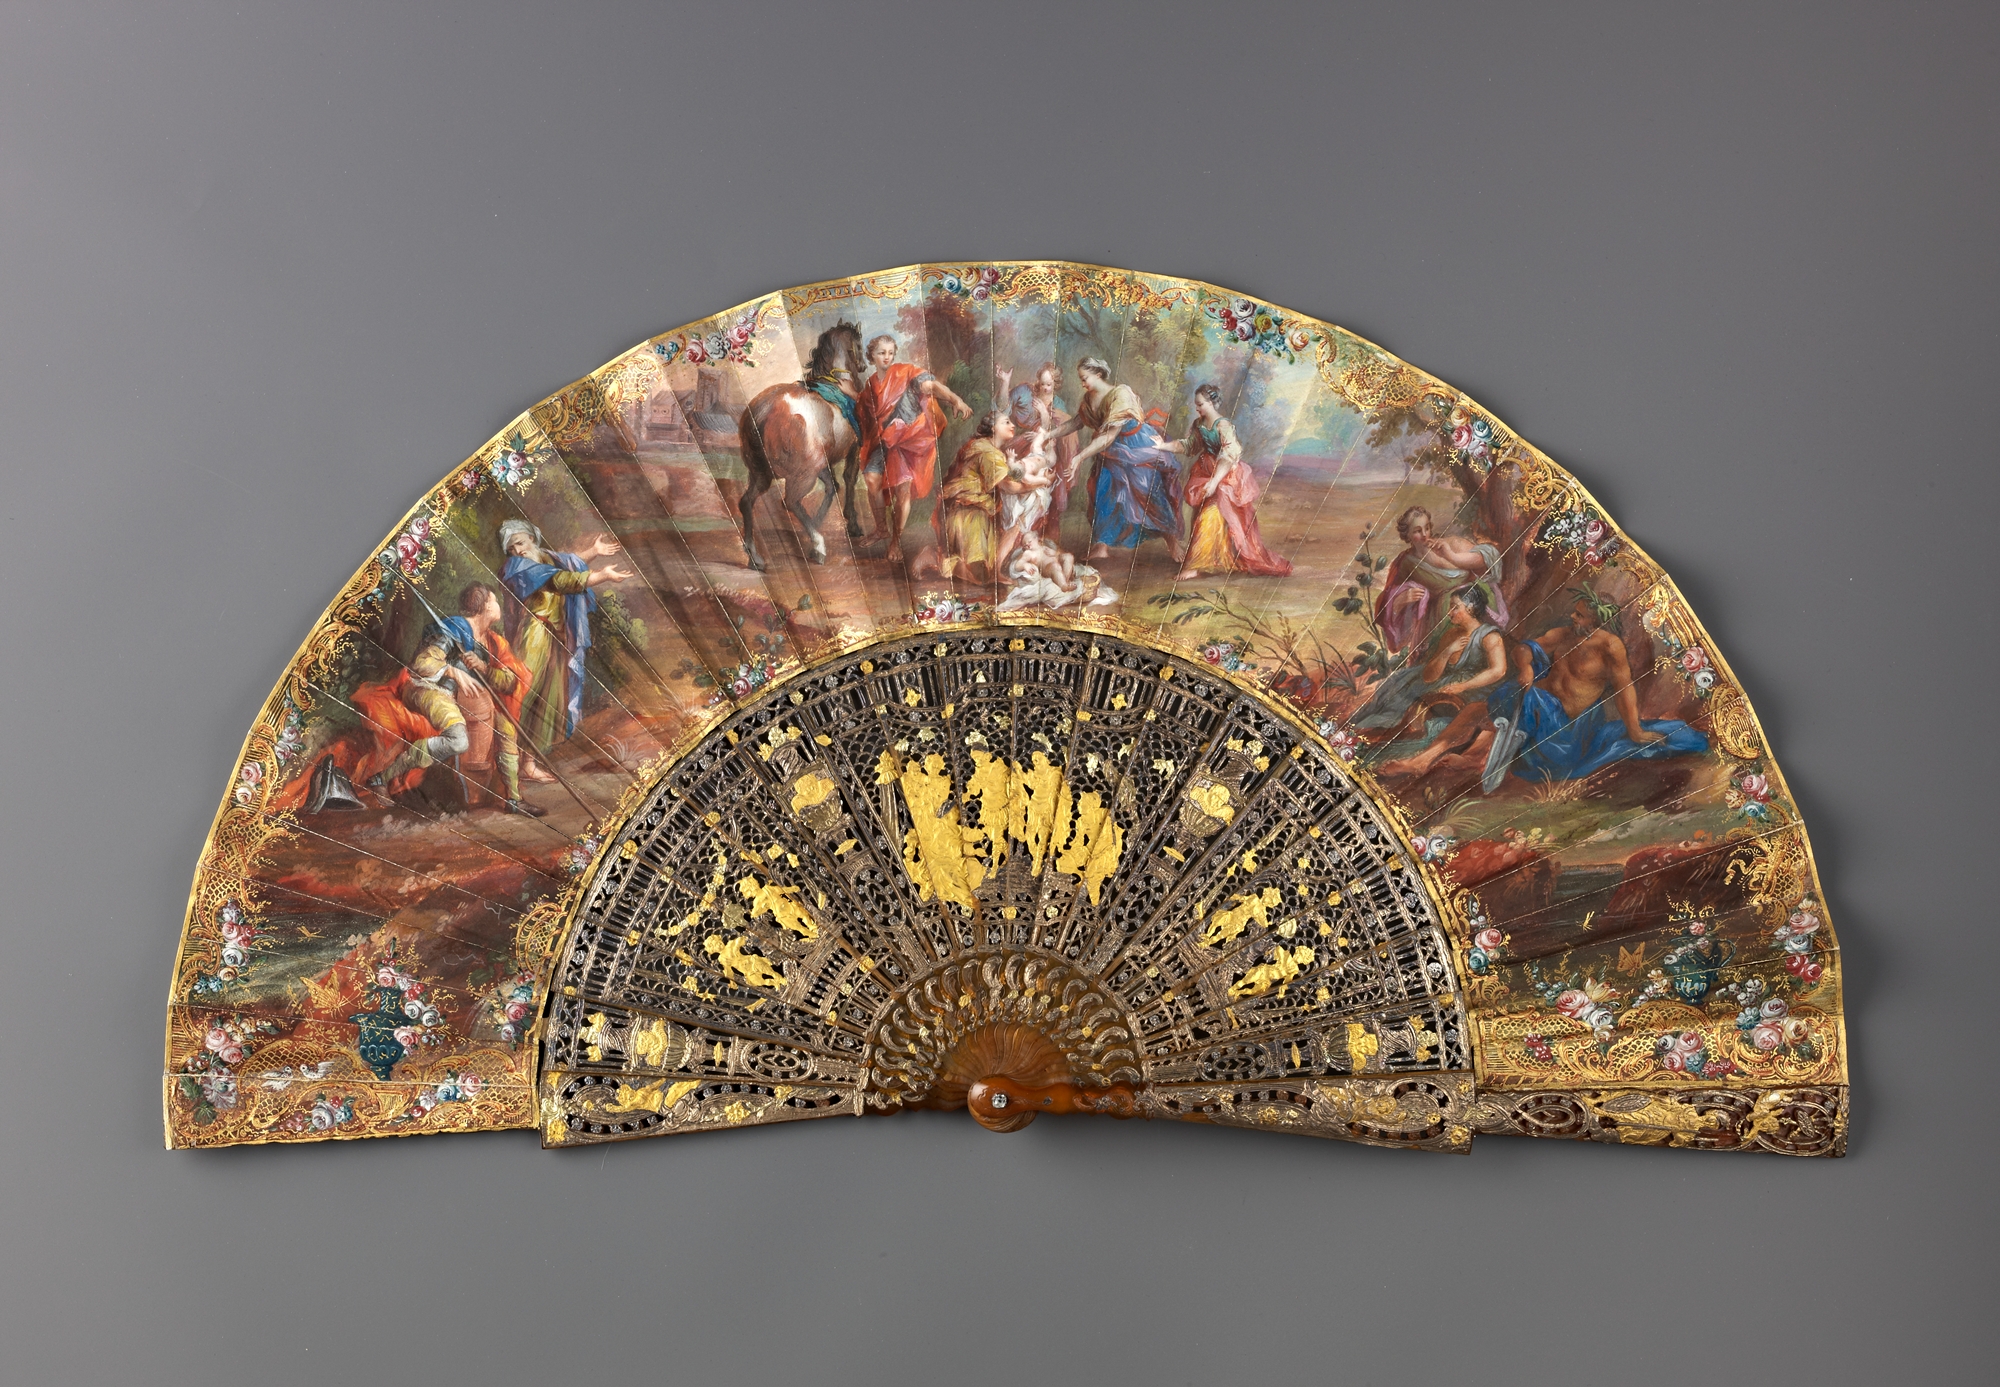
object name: fan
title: Folding fan with The Finding of Romulus and Remus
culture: italian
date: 1734-1766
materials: bronze, gold, gouache, metal leaf, mother of pearl, paint, paper, paste, silver, shell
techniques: carving, veneering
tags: infants,men,women,horses